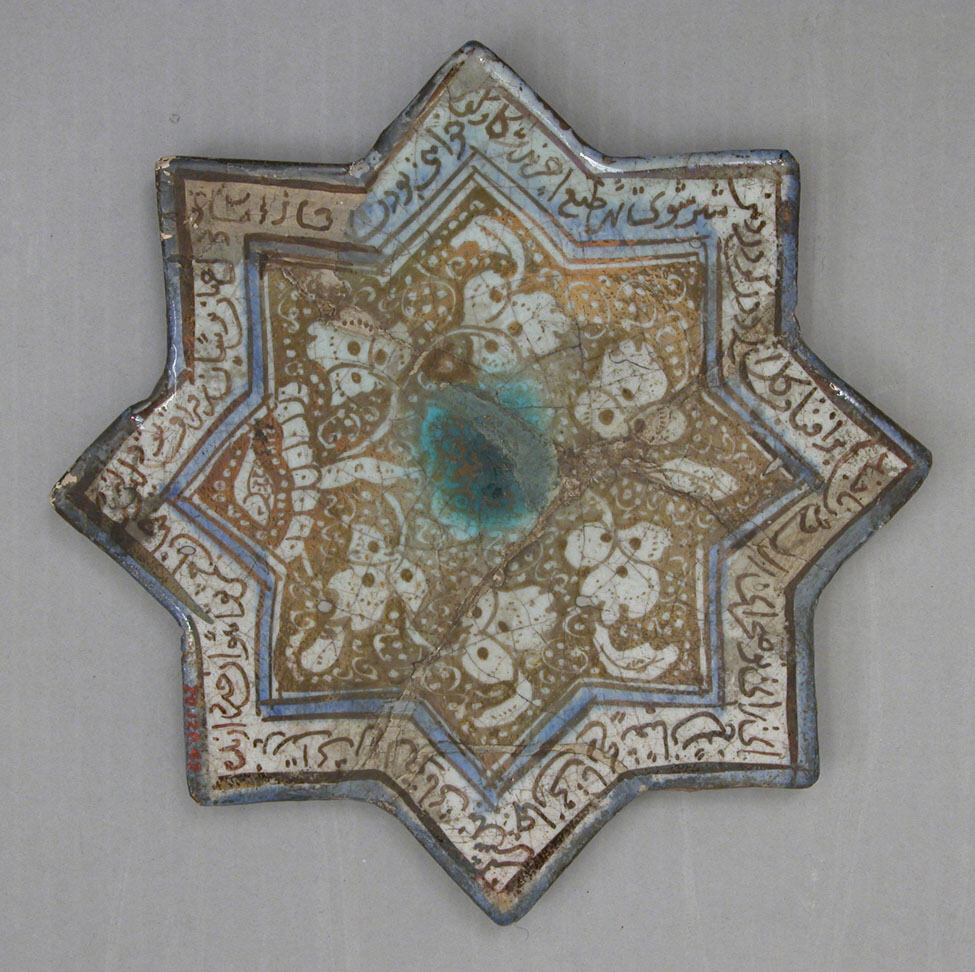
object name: tile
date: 1301-1333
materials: stonepaste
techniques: painting, underglaze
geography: iran